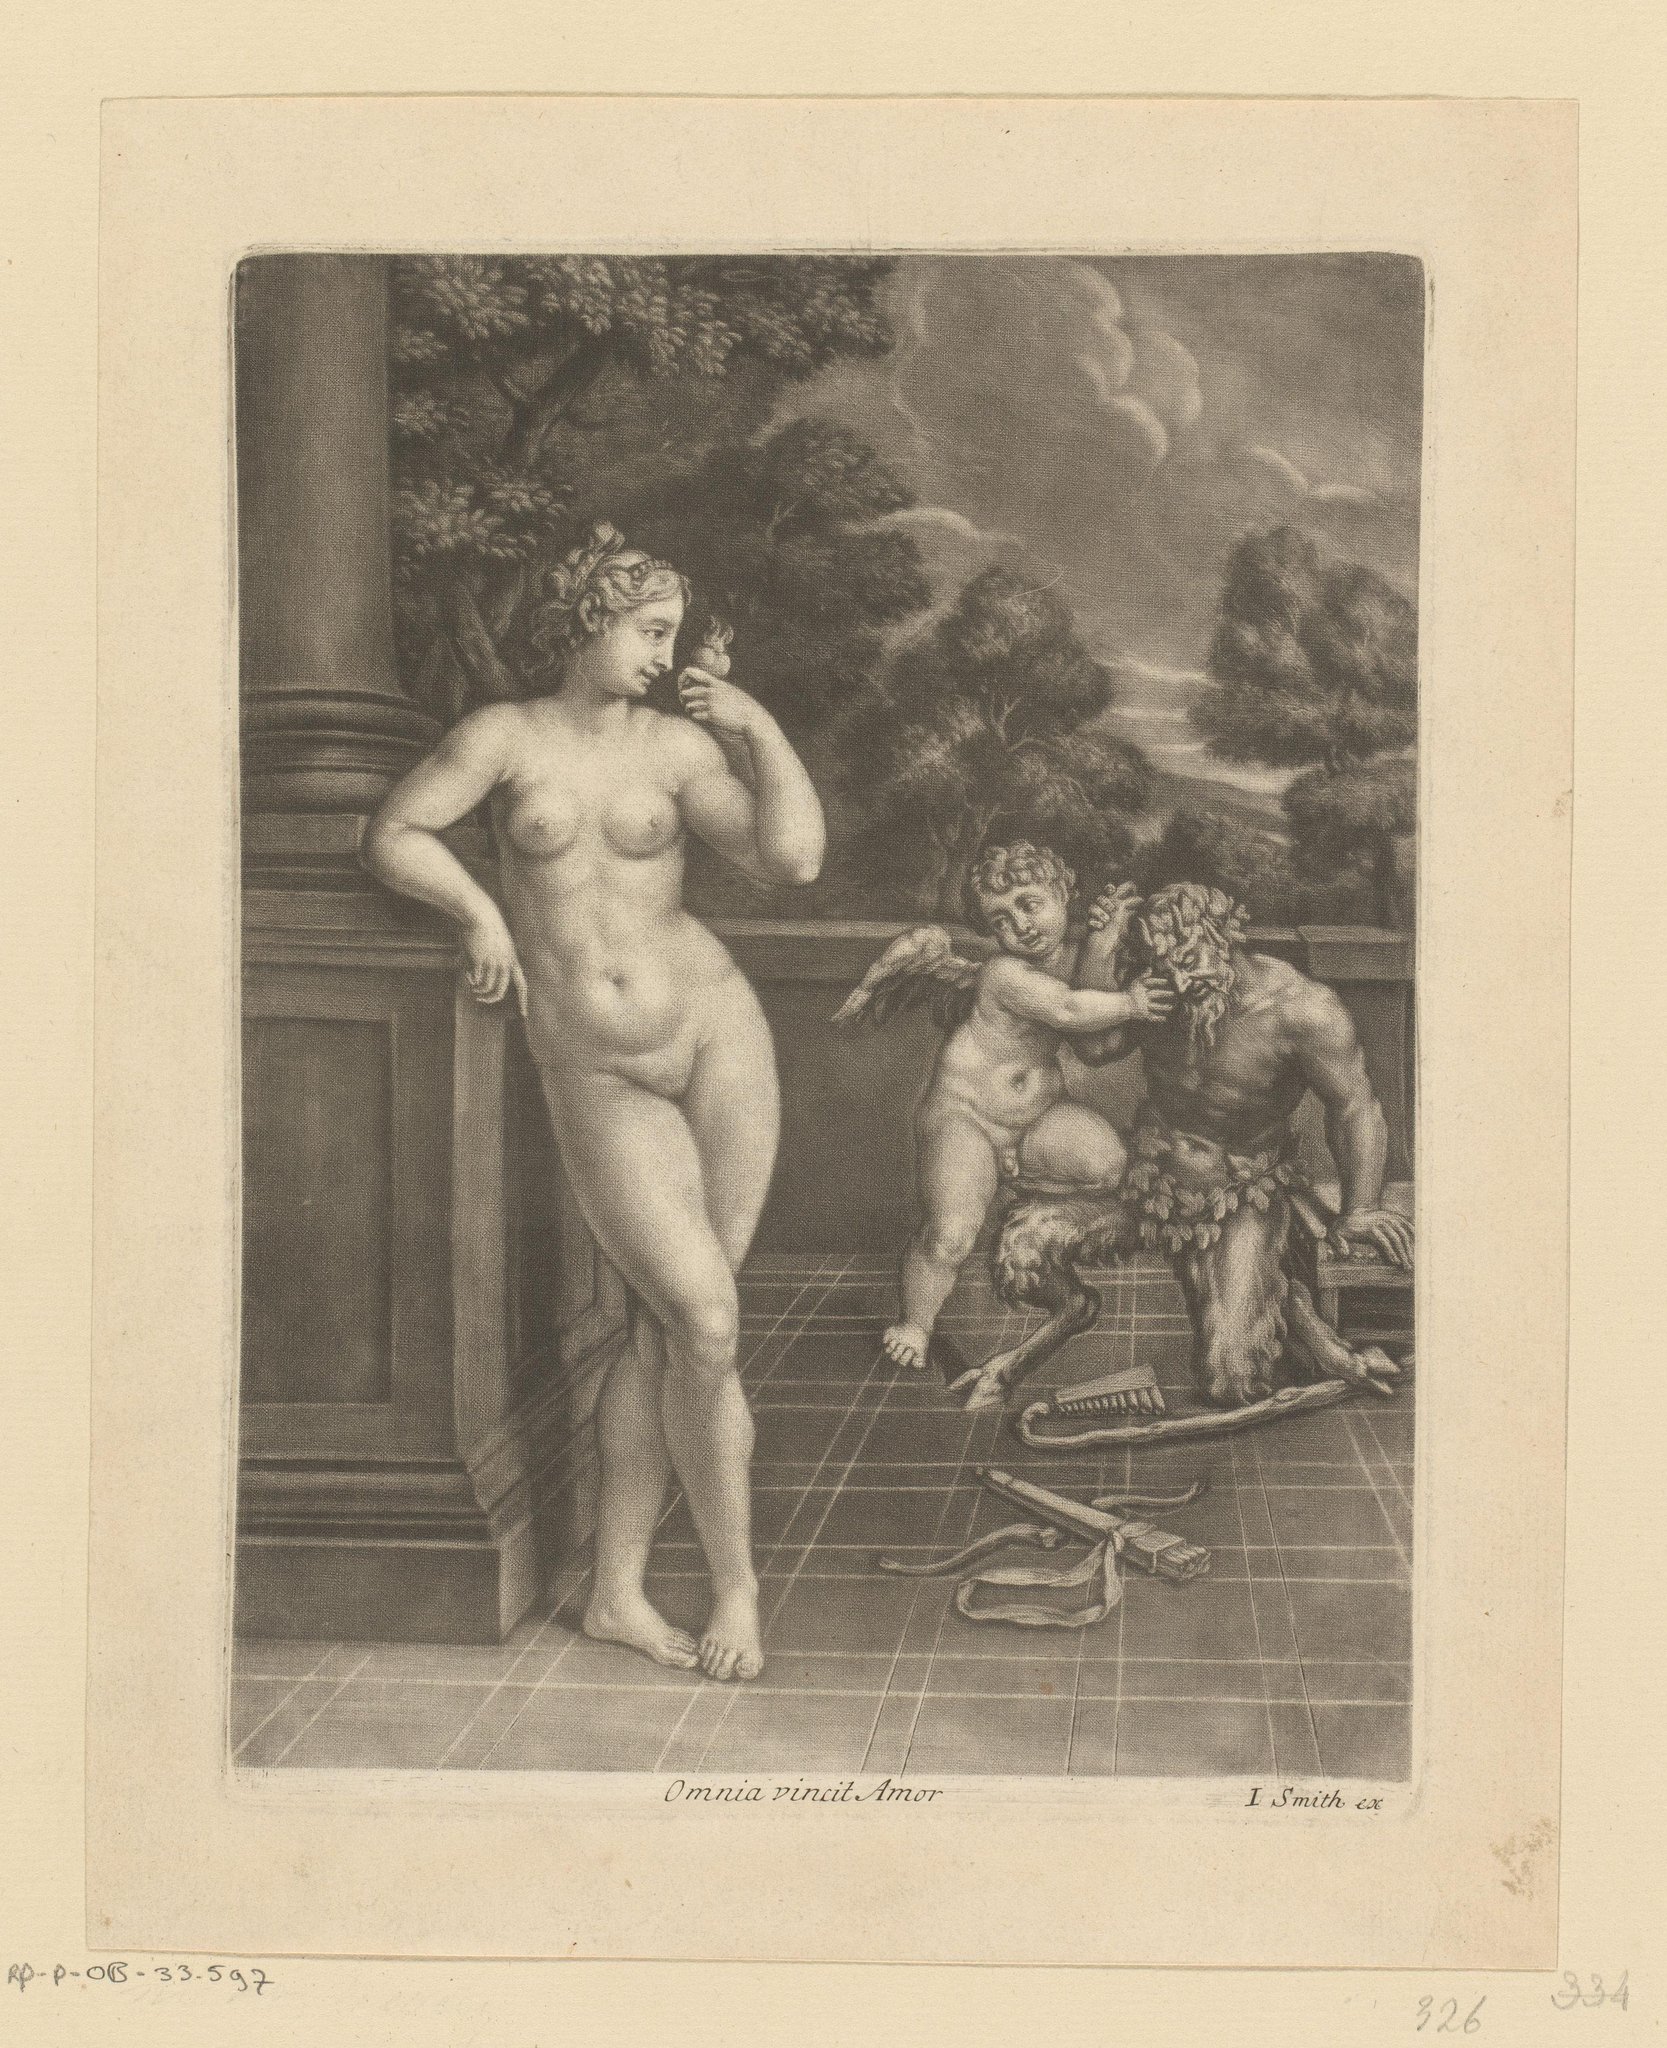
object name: print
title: Venus kijkt naar Amor, die Pan overwint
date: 1700-1729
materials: paper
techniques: etching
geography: london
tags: (story of) venus (aphrodite), cupid vanquishing pan, 'omnia vincit amor', love the conqueror, love triumphant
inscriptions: collector's mark: Lugt 240